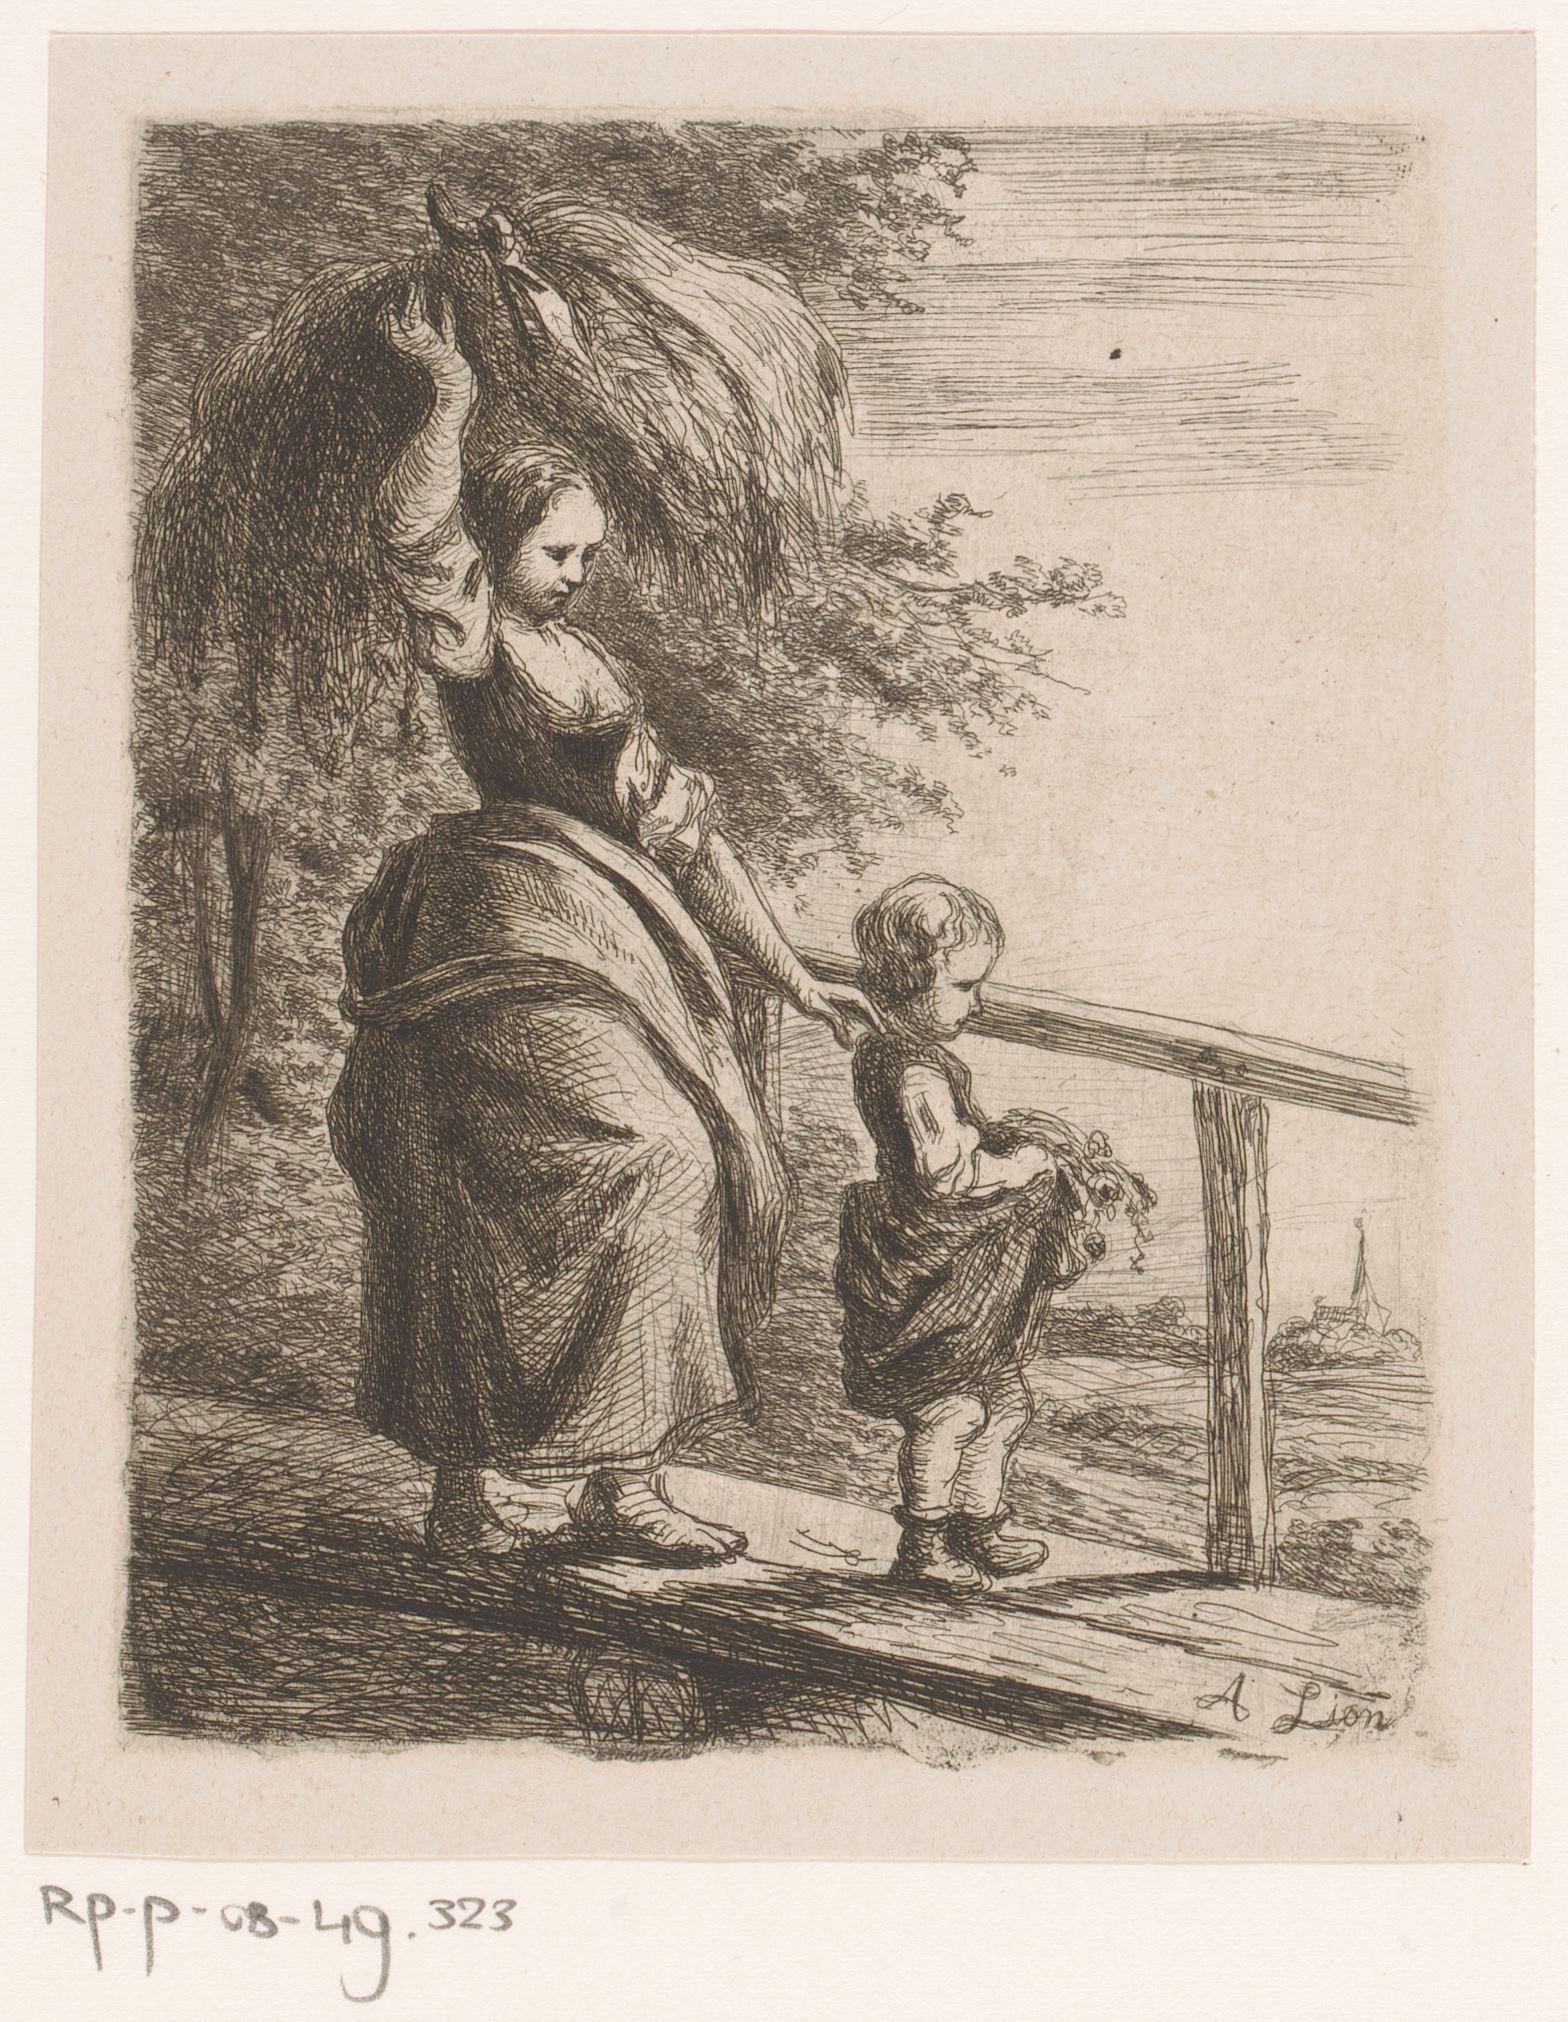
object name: print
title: Vrouw draagt hooi op het hoofd en leidt een kind over een houten brug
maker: alexandre louis lion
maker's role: print maker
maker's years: 1823-1852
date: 1833-1852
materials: paper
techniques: drypoint, etching, intaglio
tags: mother and child(ren), woman and child(ren) (family group)